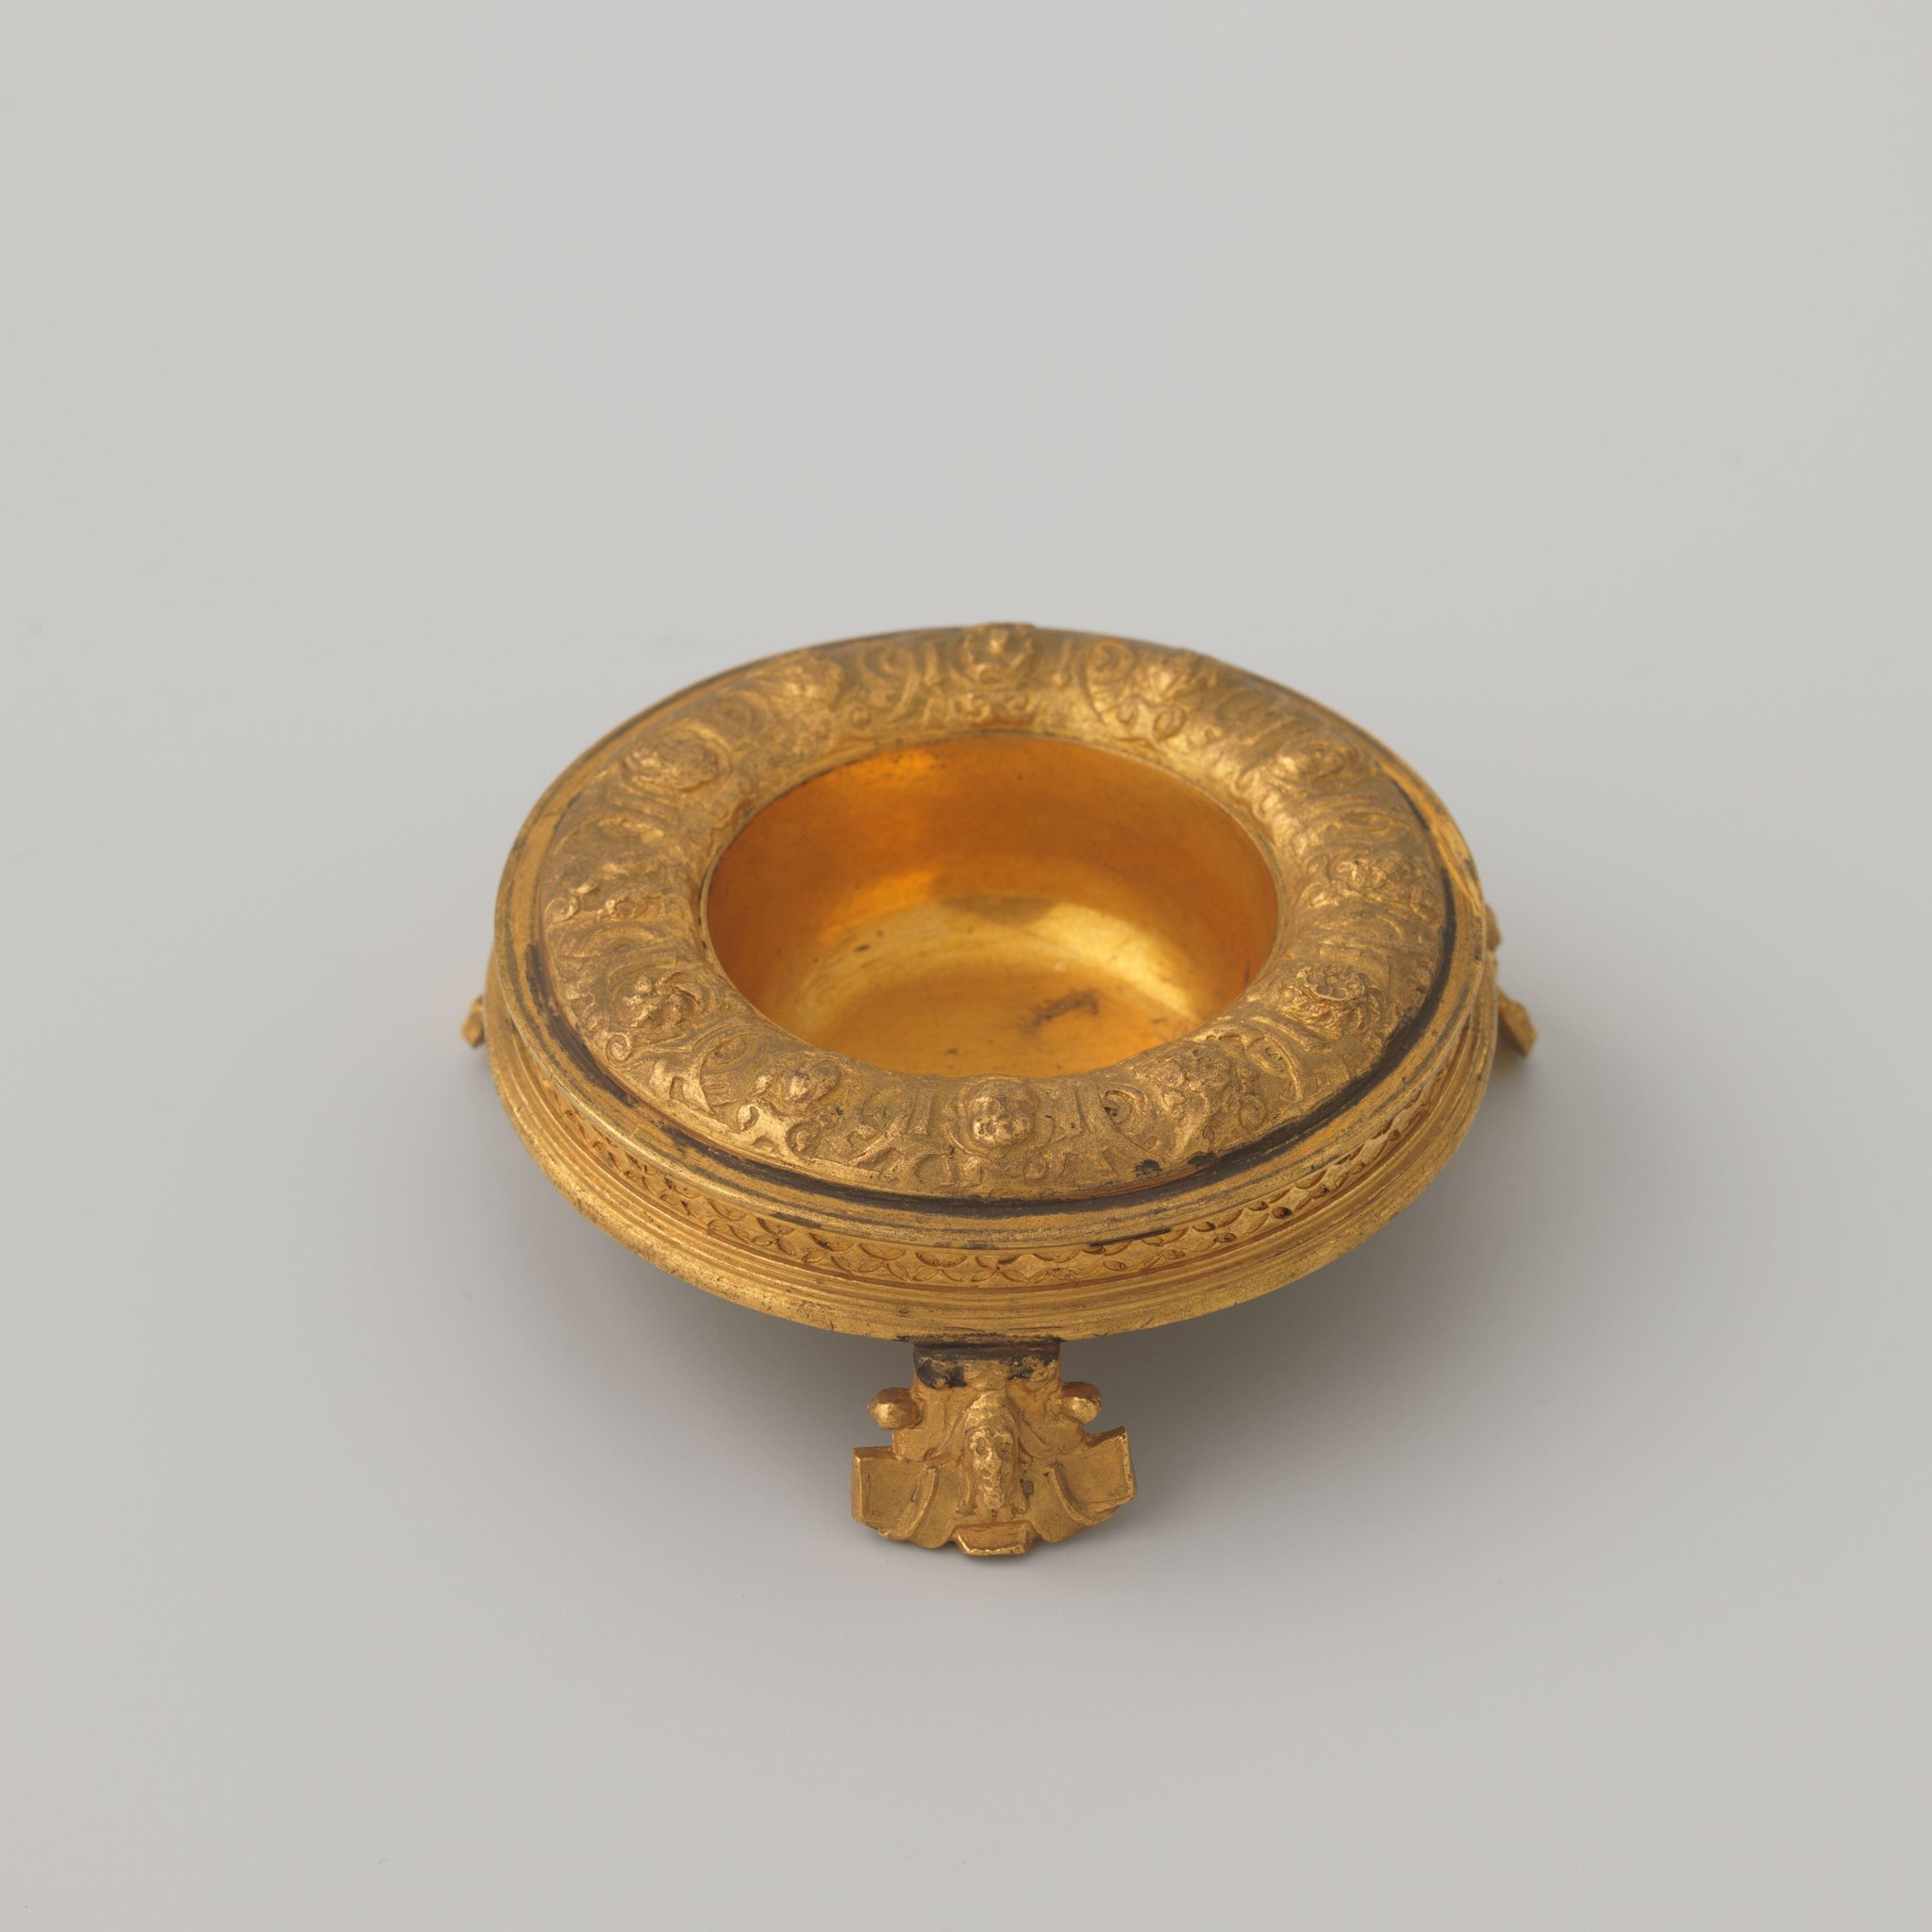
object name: salt condiment vessel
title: Galvanoplastische reproductie van een rond zoutvat versierd met bandwerk en maskerons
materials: copper, silver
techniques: gilding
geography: london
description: Galvanoplastische reproductie van een rond zoutvat waarvan de rand versierd is met gedreven en gahamerd bandwerk en maskerons. Het zoutvat wordt gedragen door drie maskerons. Verguld.